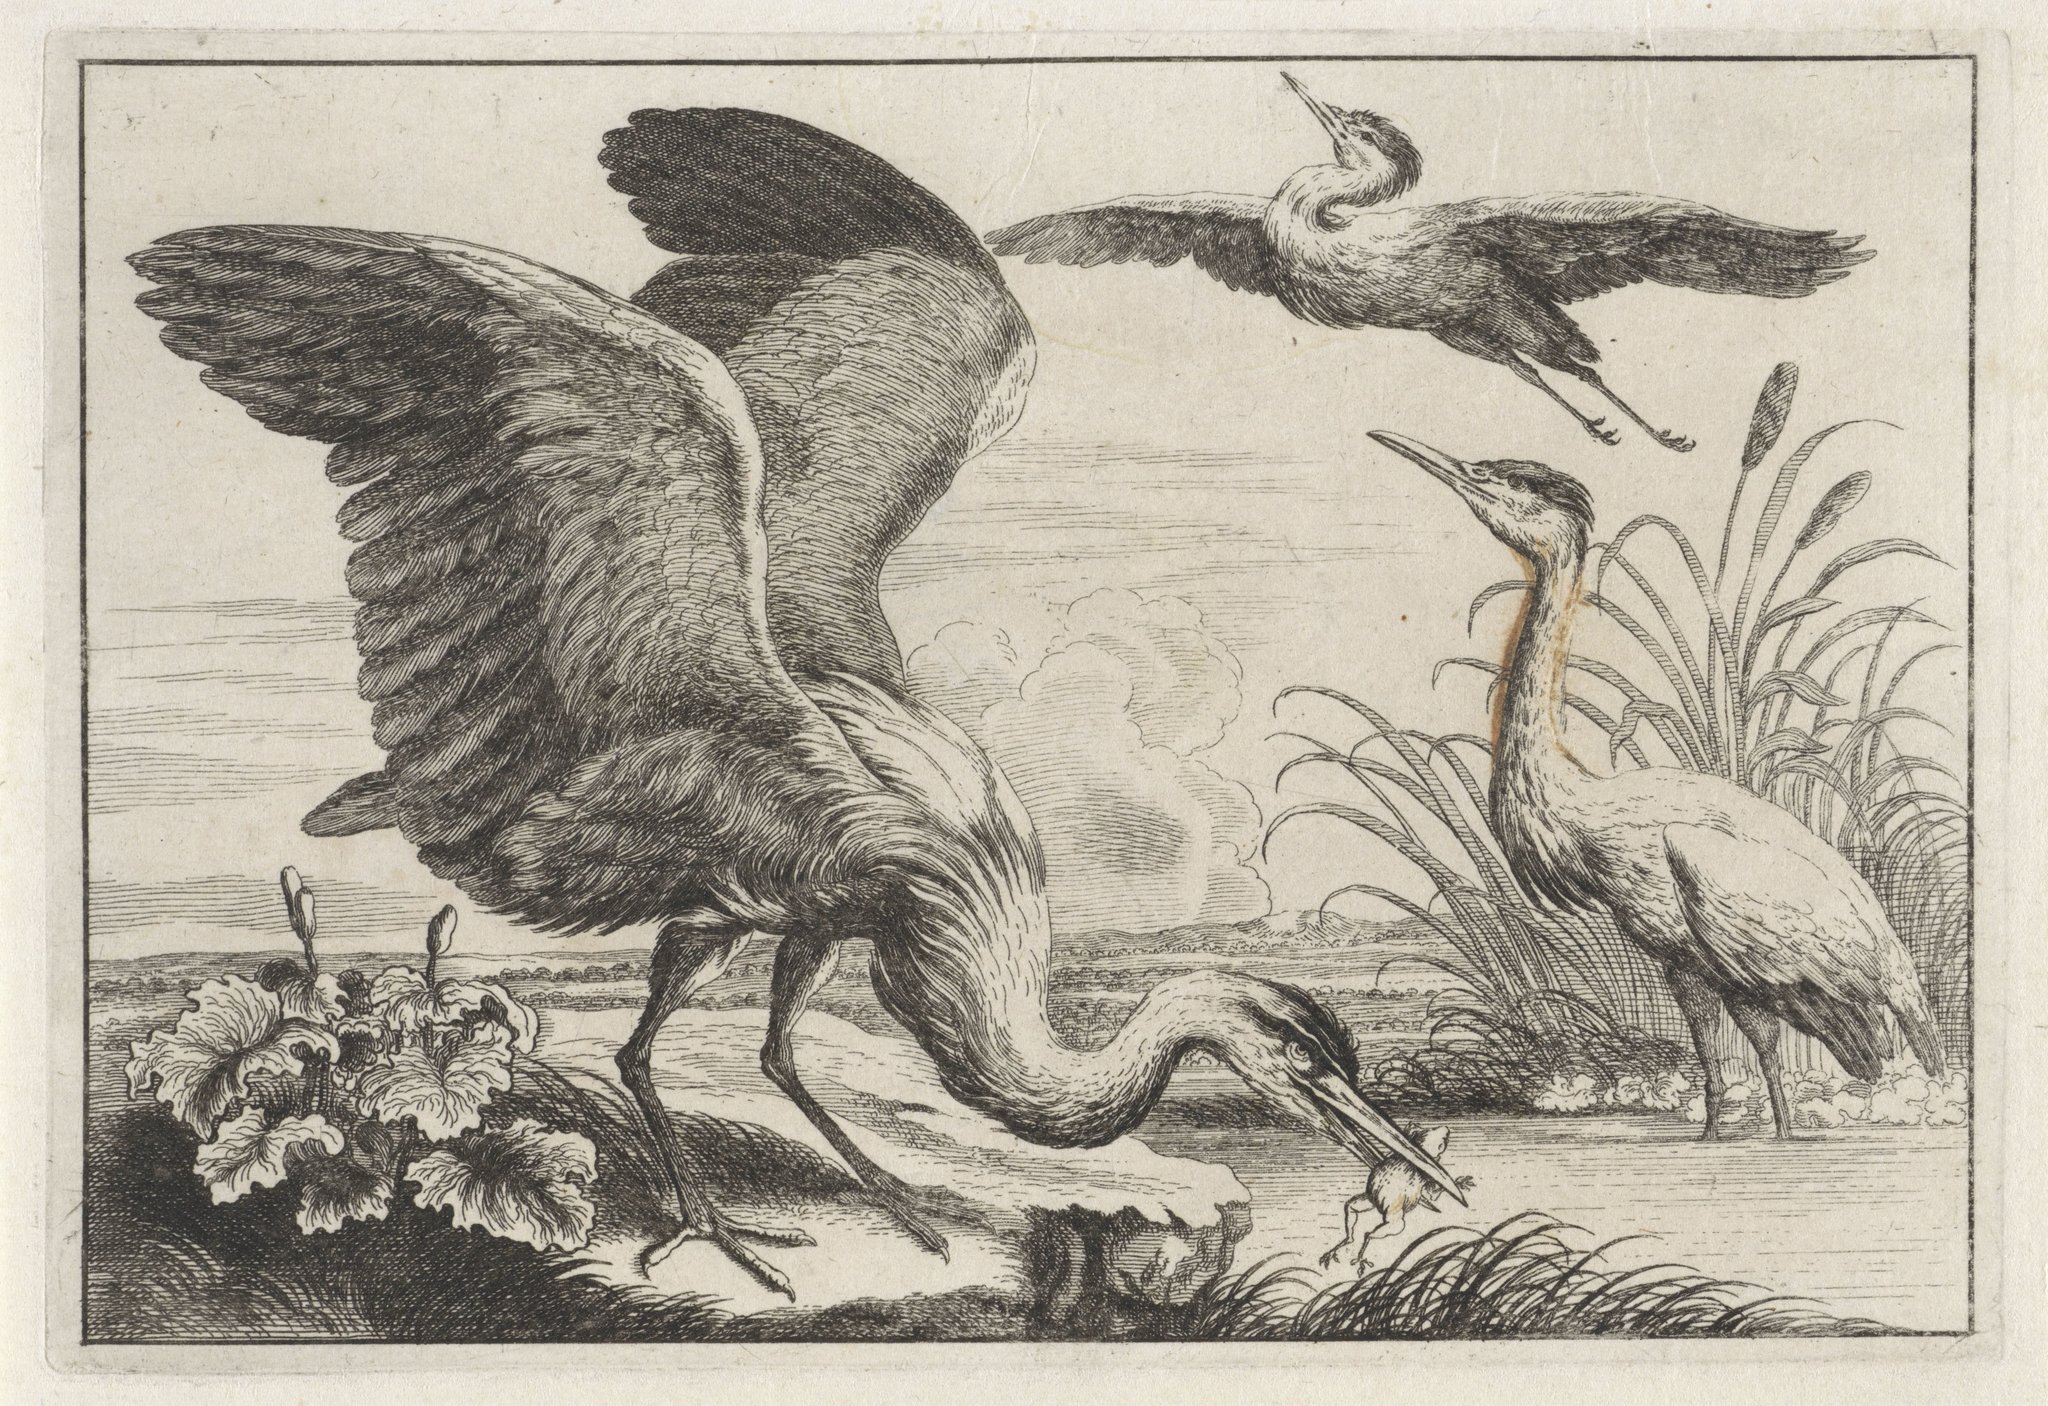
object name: print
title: Verschillende vogels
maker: Anonymous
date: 1654-1712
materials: paper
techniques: etching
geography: london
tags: shore-birds and wading-birds: heron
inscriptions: collector's mark: Lugt 2760, collector's mark: Lugt 2228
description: Kopie naar prent die deel uitmaakt van de negendelige serie met voorstellingen van verschillende vogels: "Diversae avium species".